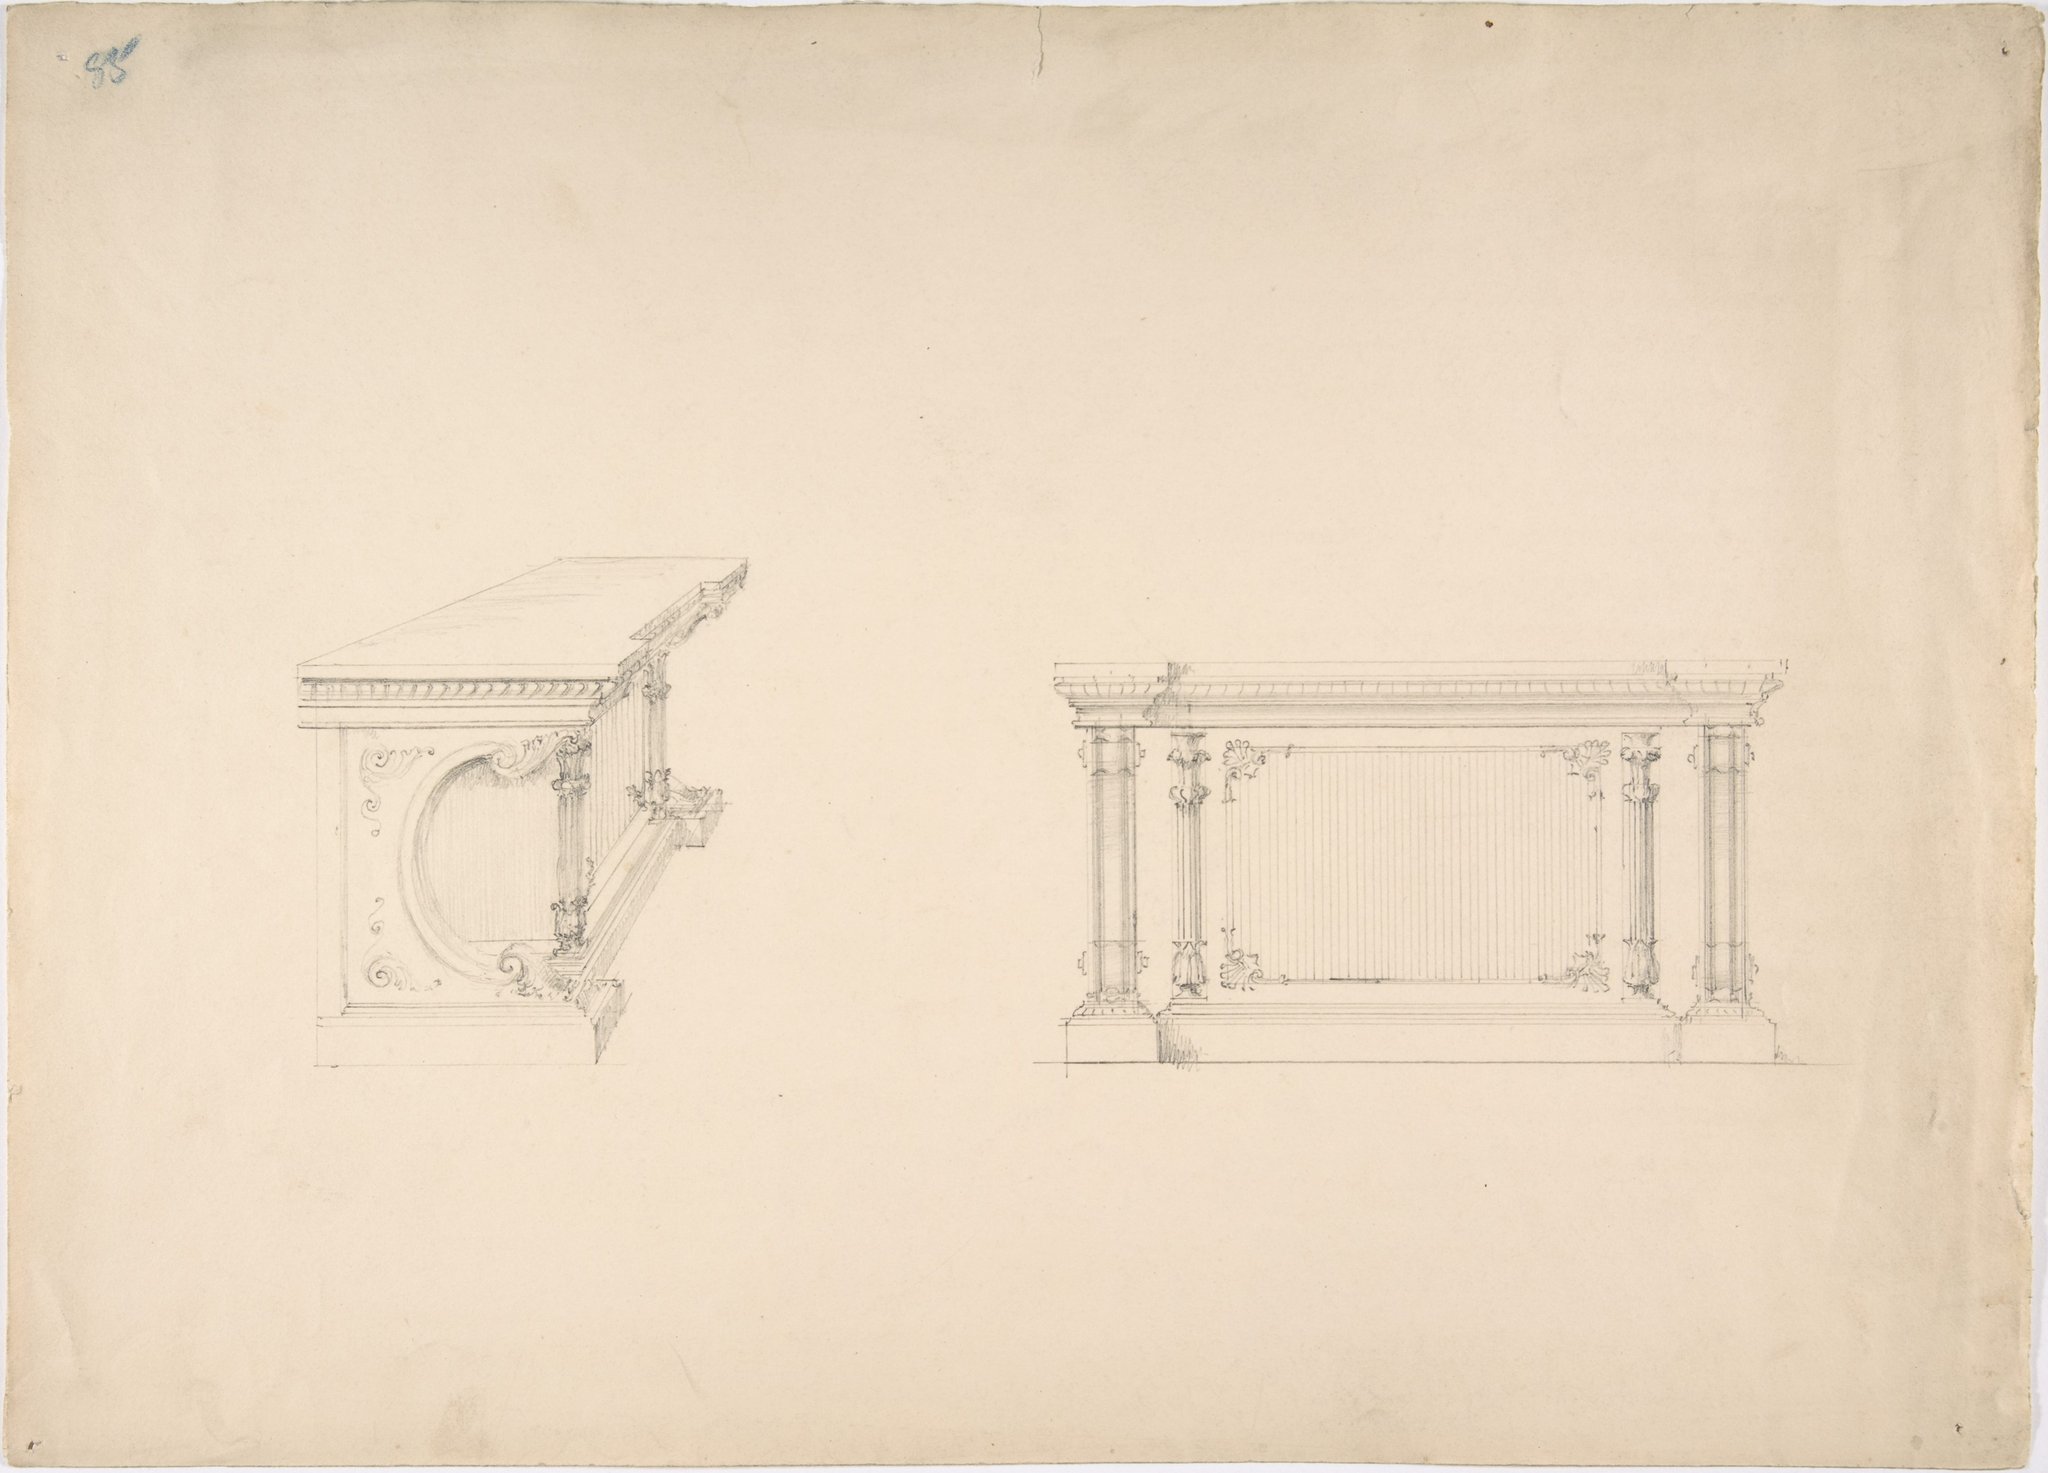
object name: drawing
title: Design for a Cabinet with Columns and Inset Fabric Panels: Elevation and Side View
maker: anonymous, british, 19th century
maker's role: artist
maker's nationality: british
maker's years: 1800-1900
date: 1801-1833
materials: graphite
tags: cabinets